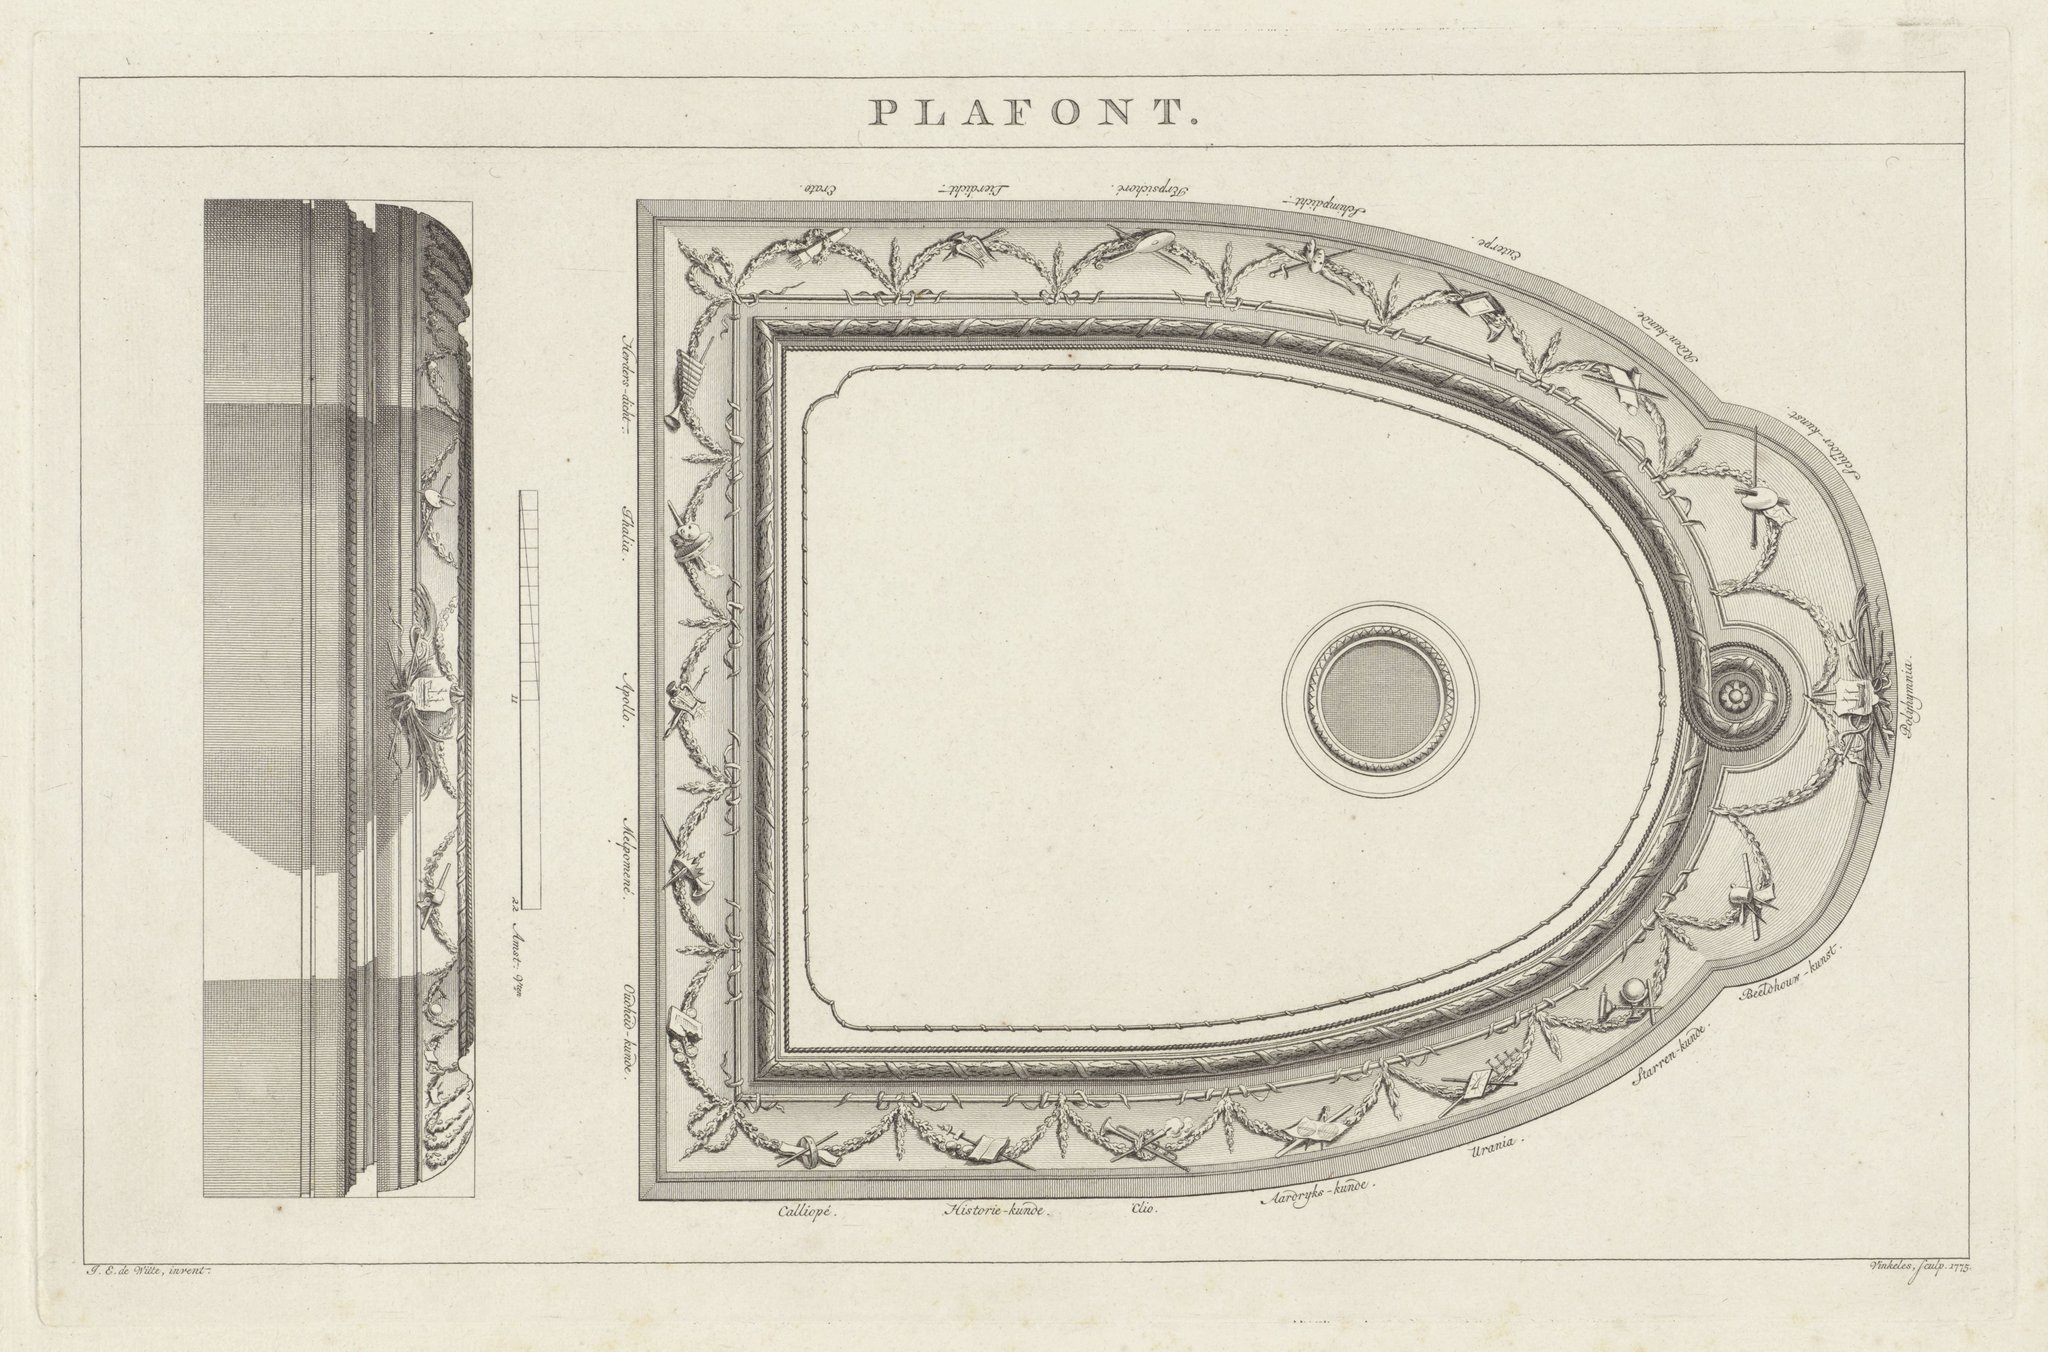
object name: print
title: Plafond van de schouwburg aan het Leidseplein te Amsterdam, 1775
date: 1774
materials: paper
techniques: engraving, etching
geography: amsterdam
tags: theatre (building), amsterdam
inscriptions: collector's mark: Lugt 2228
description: Illustratie voor: Witte, Jacob Eduard de. Afbeeldingen van den schouwburg te Amsterdam. Amsterdam: Johannes Smit, 1774.